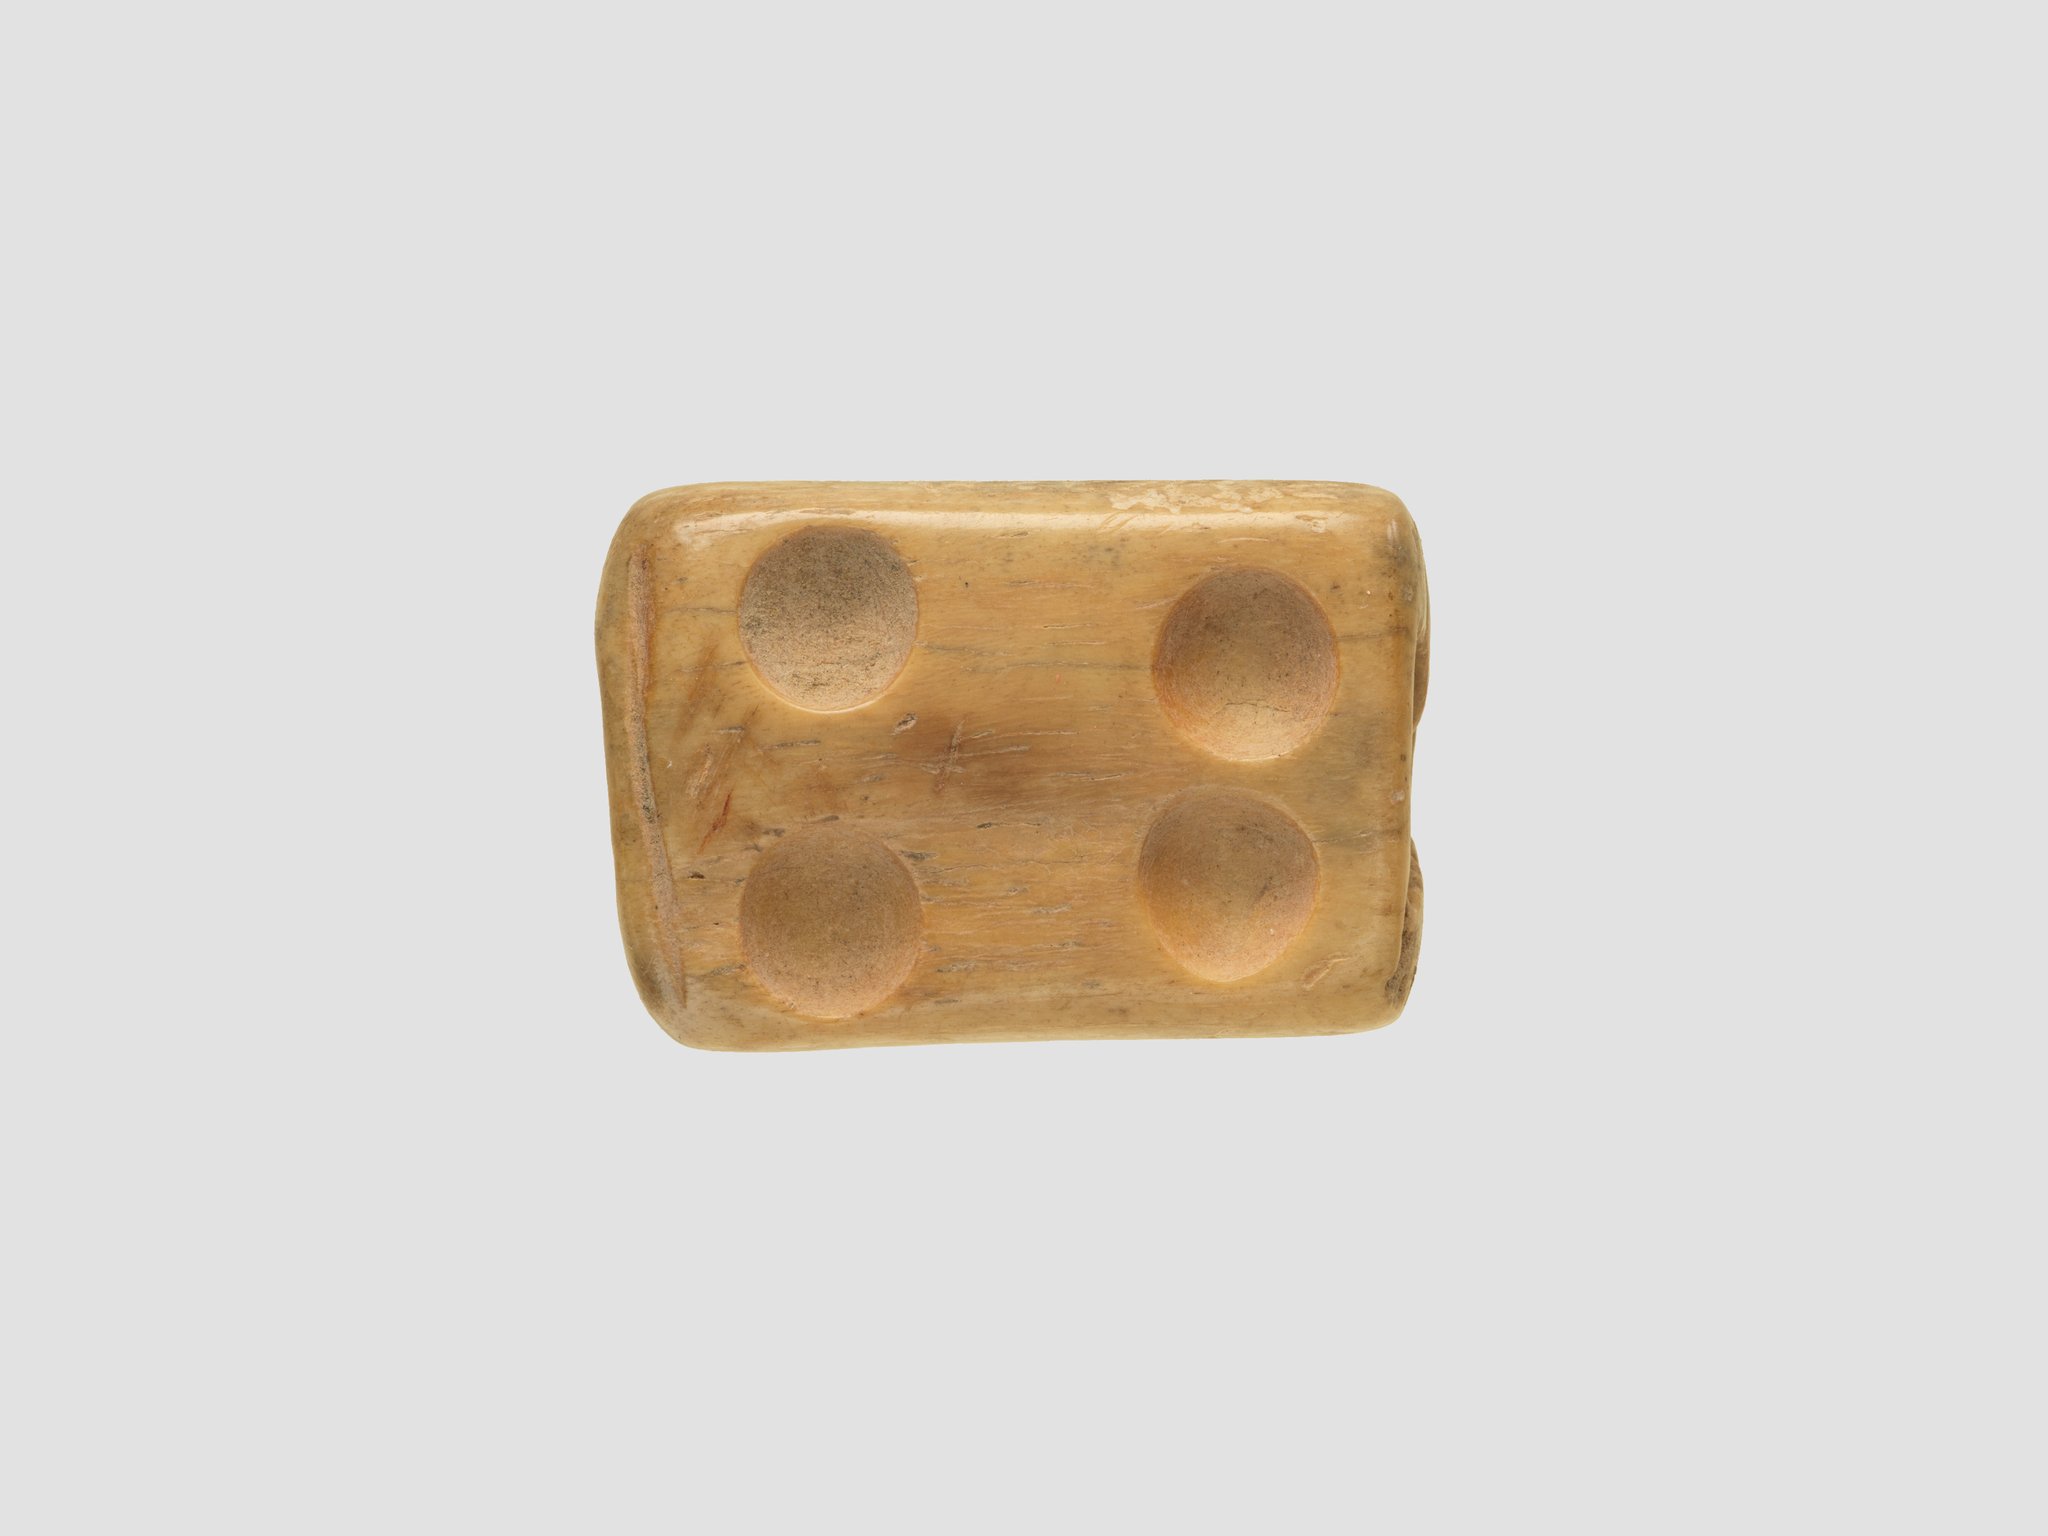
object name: bead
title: Bead (?)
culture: iranian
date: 900-801 BCE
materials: bone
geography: iran